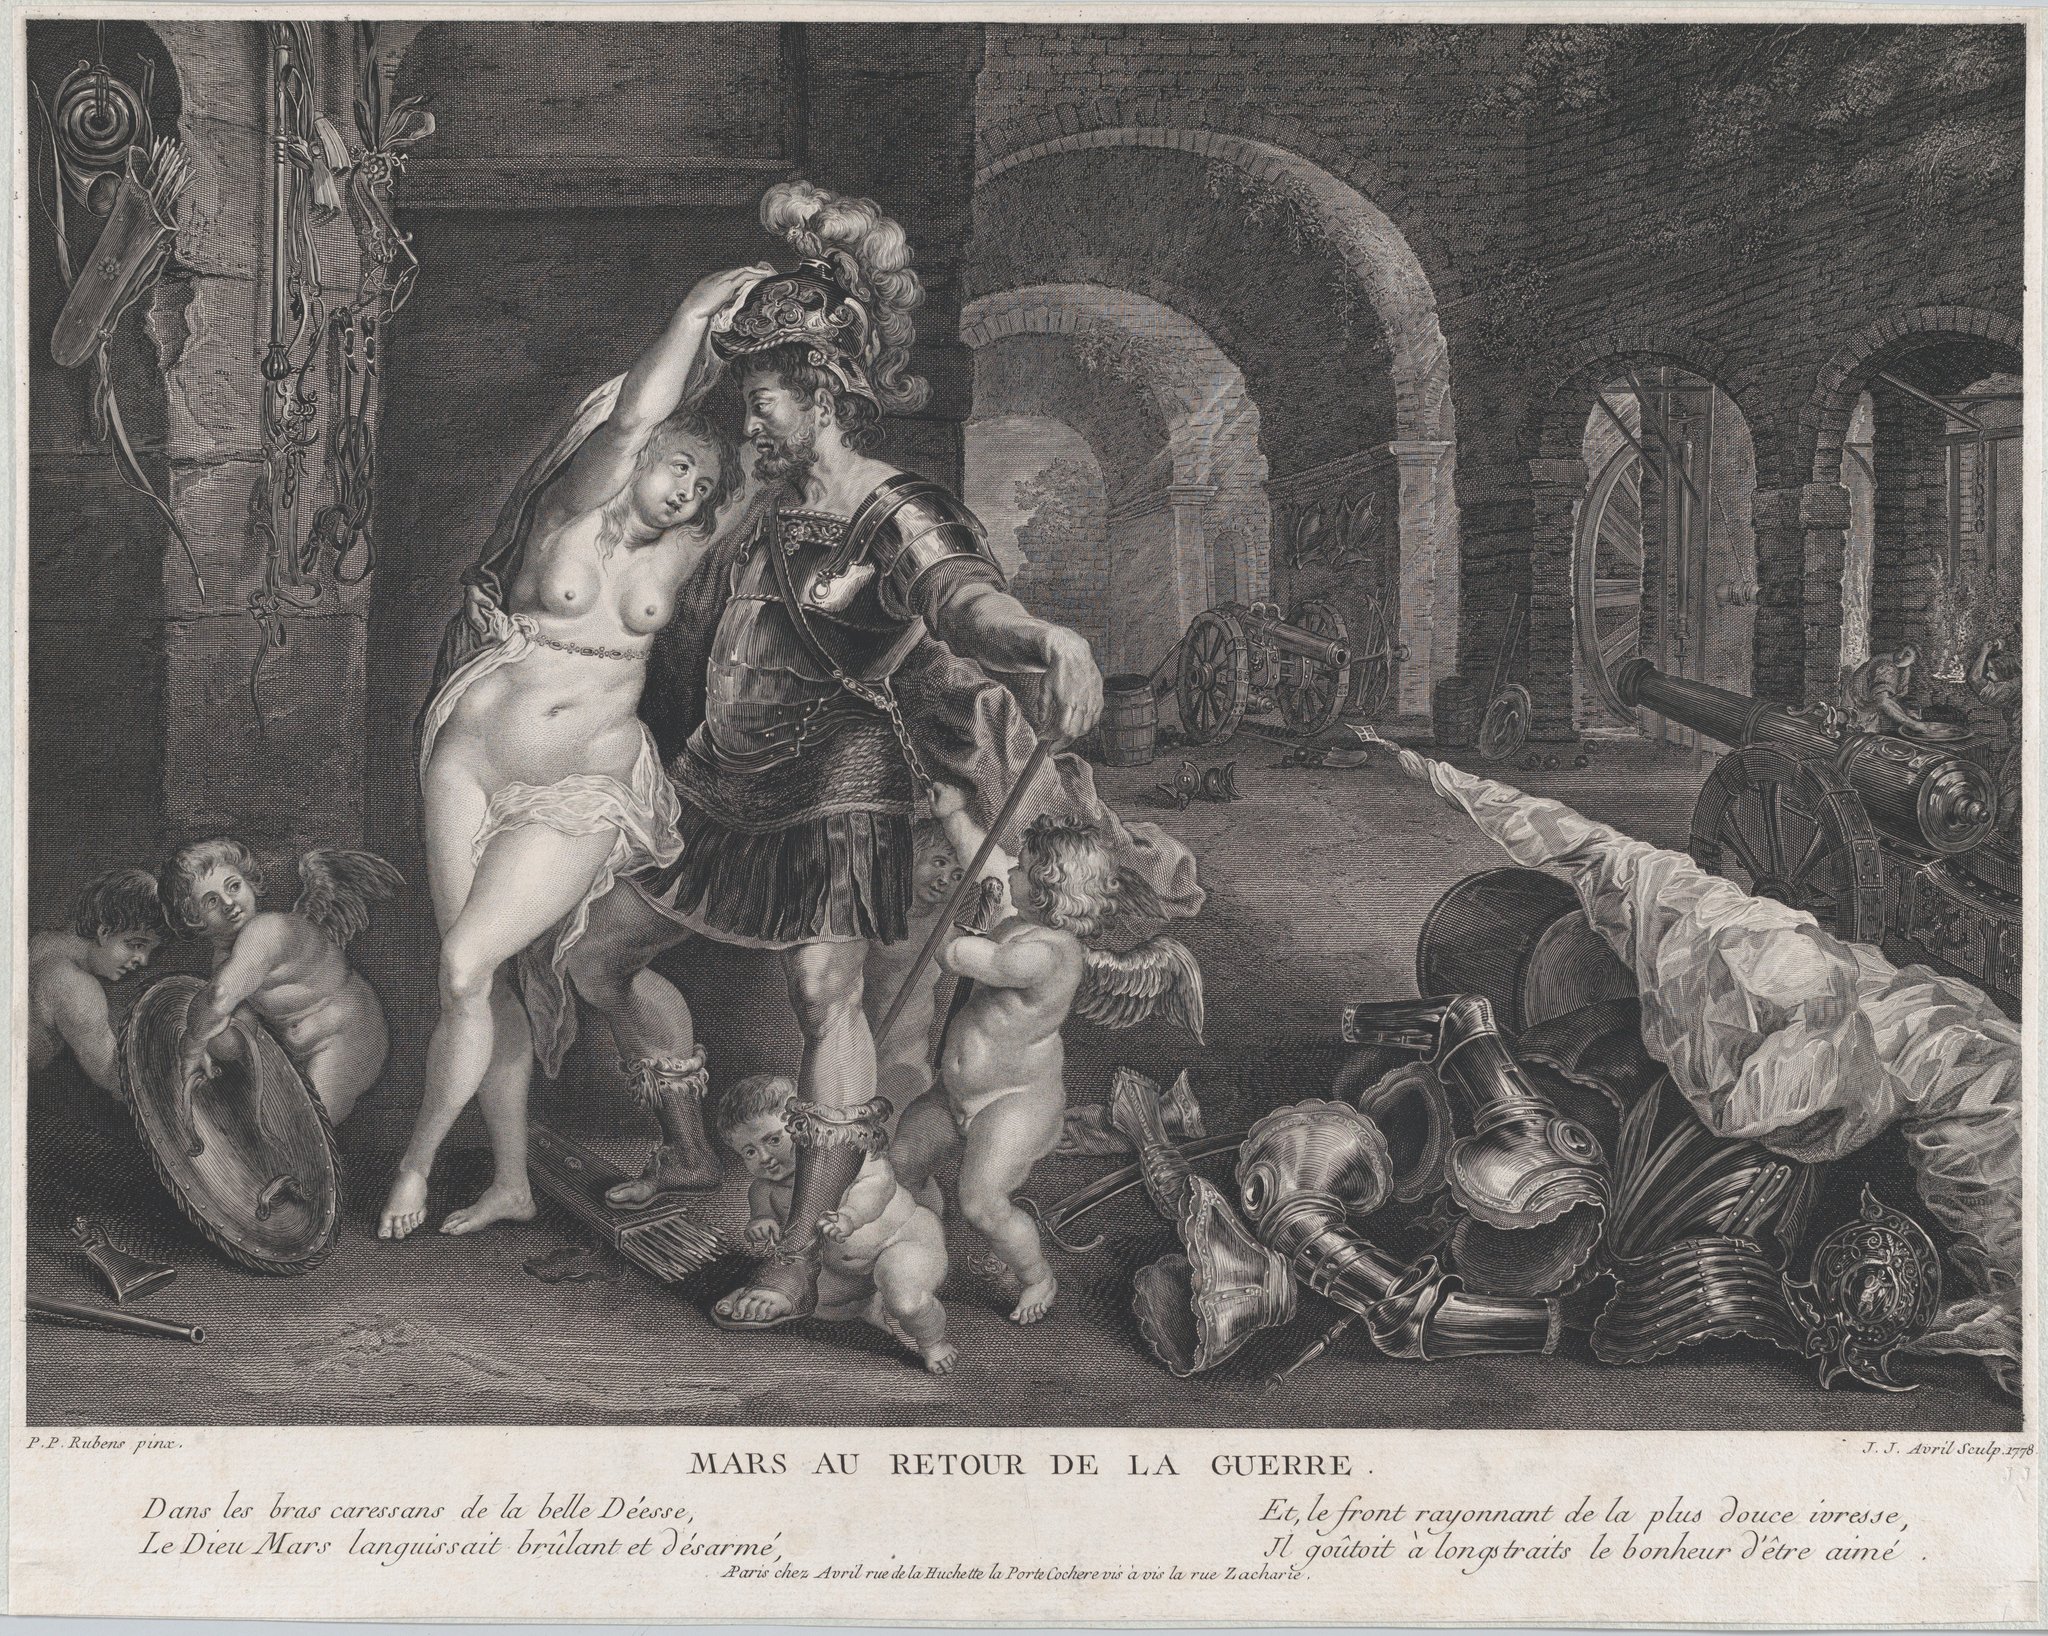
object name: print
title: The Return from War: Mars Disarmed by Venus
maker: jean jacques avril, the elder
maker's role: artist and publisher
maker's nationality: french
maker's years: 1744-1831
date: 1778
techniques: engraving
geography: paris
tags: armor,cannons,putti,mars,venus